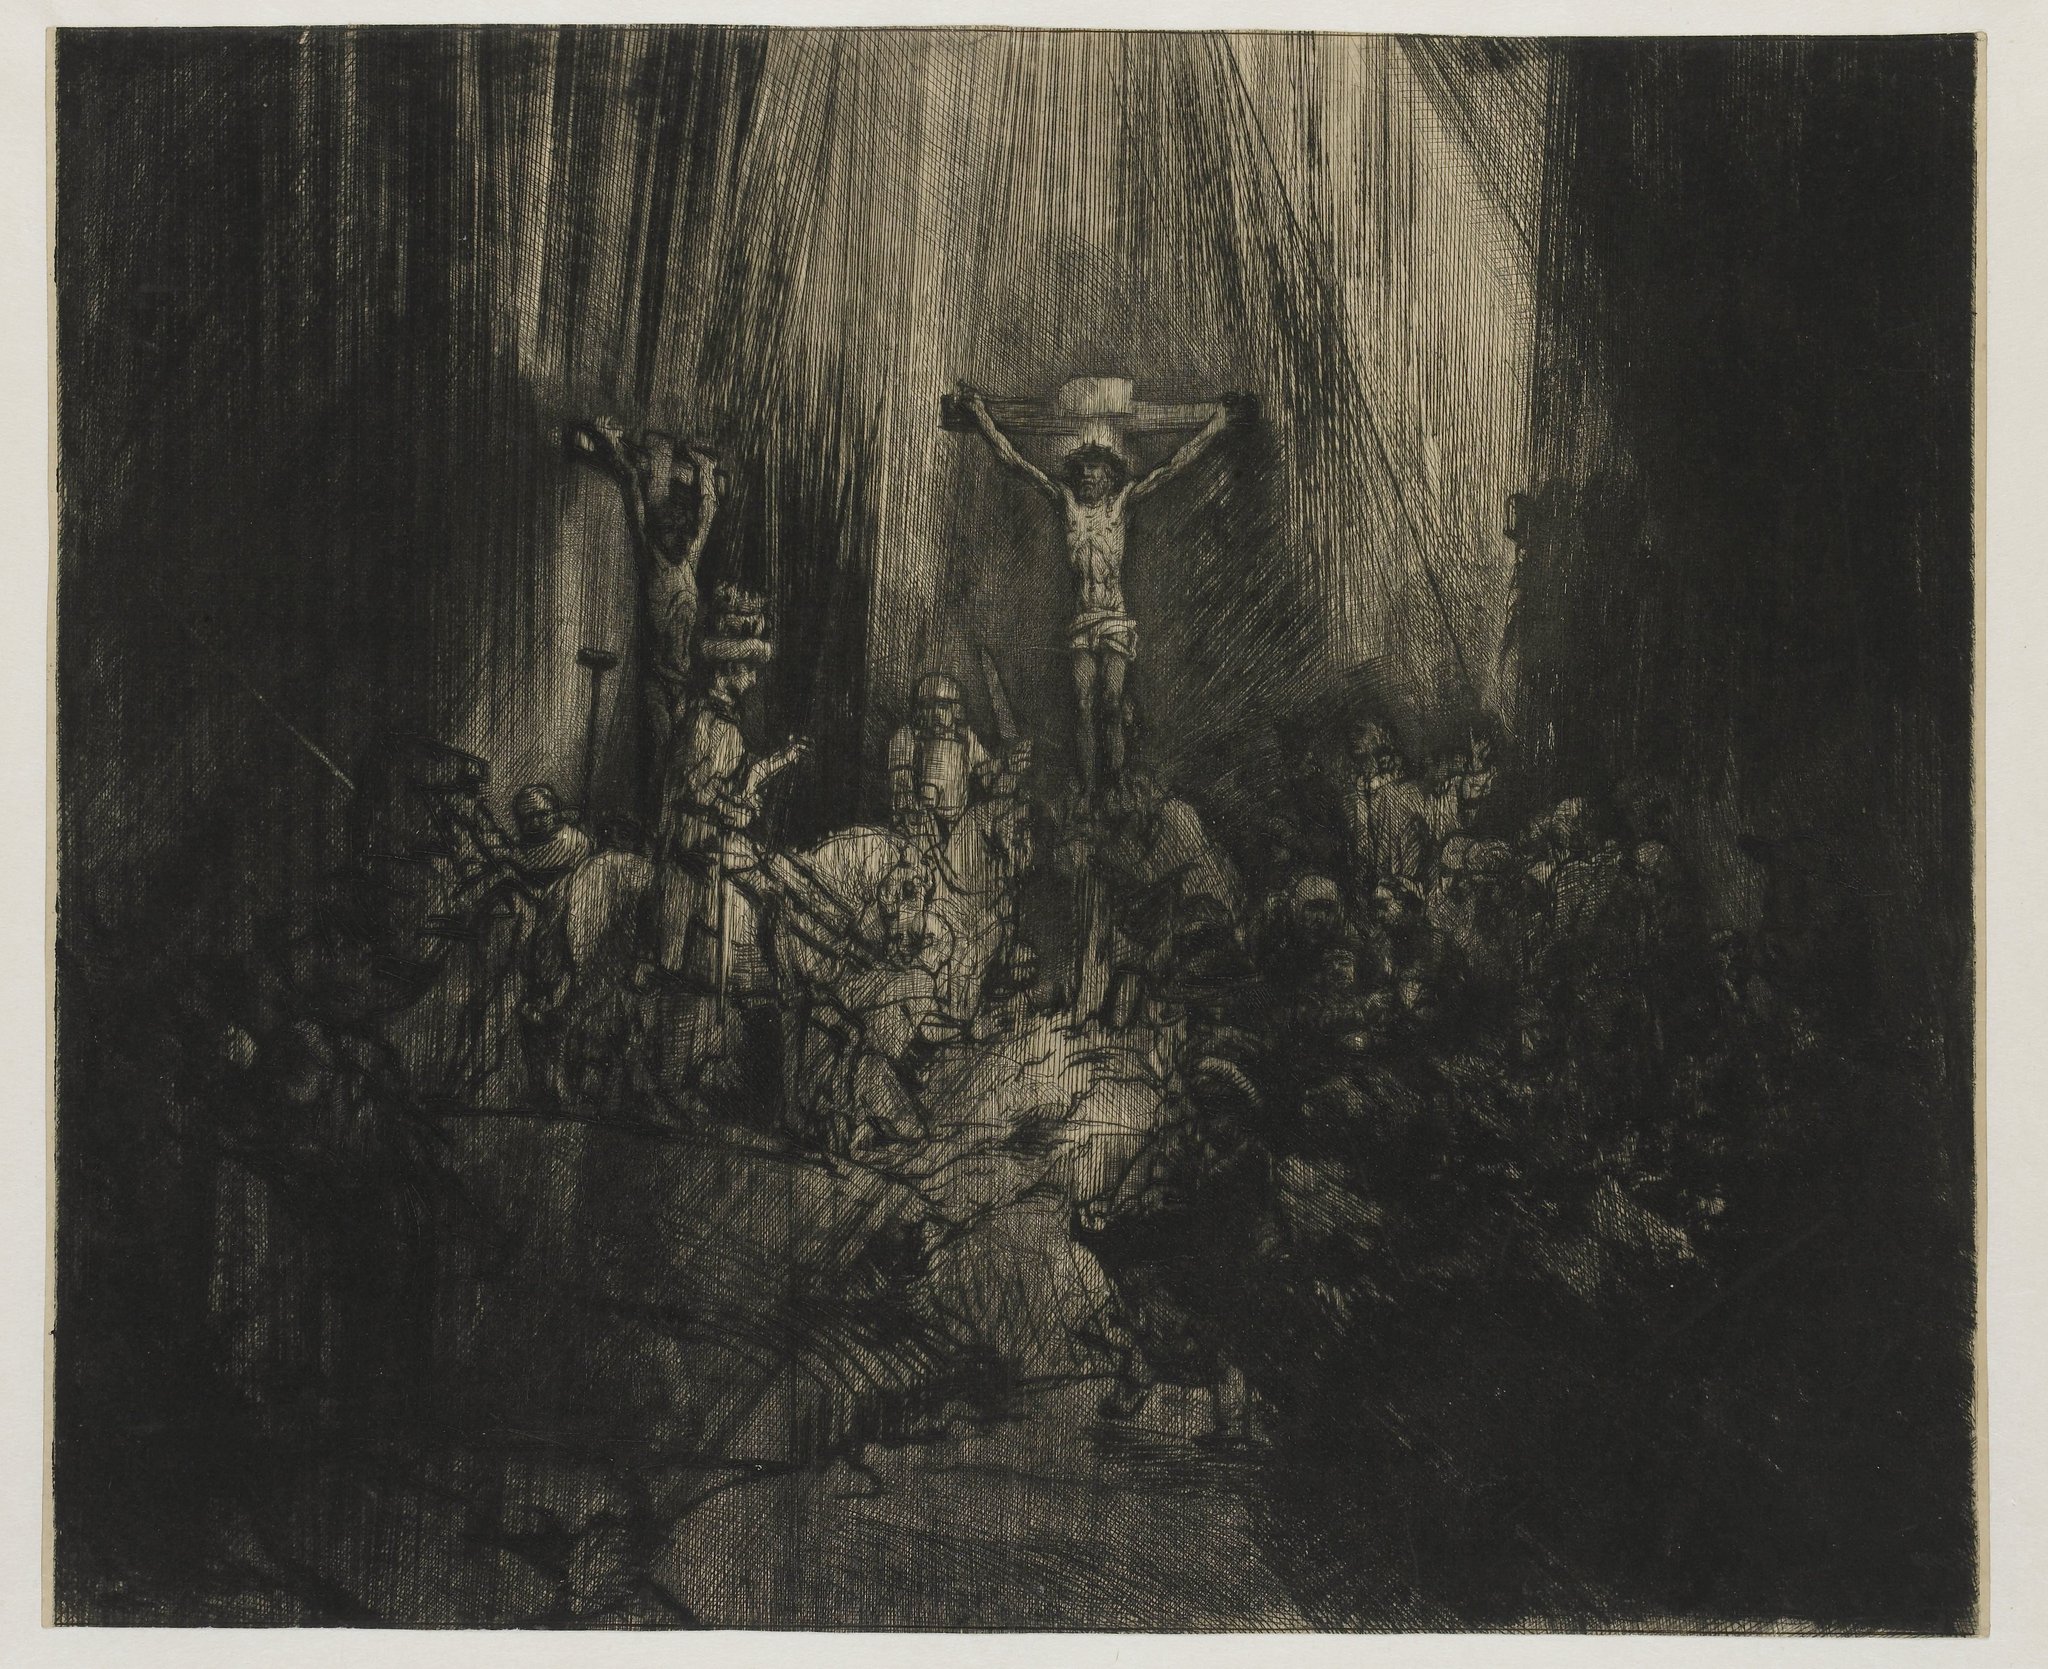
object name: print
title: The Three Crosses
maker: rembrandt van rijn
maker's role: draughtsman, painter, print maker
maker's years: 1606-1669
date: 1653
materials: paper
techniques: drypoint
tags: the crucifixion of christ: prelude to christ's death on the cross (matthew 27:34-44; mark 15:23-32; luke 23:33-43; john 19:18-24)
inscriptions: mark: Lugt 228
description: Scratching directly in an etching plate creates a ragged, raised ridge of metal shavings known as burr. This gives drypoint lines such a velvety look. However, burr wears down quickly, diminishing its decorative effect. Here Rembrandt radically solved that problem by creating an entirely new version over the old one. The subject remained the same, but the atmosphere is much more ominous.